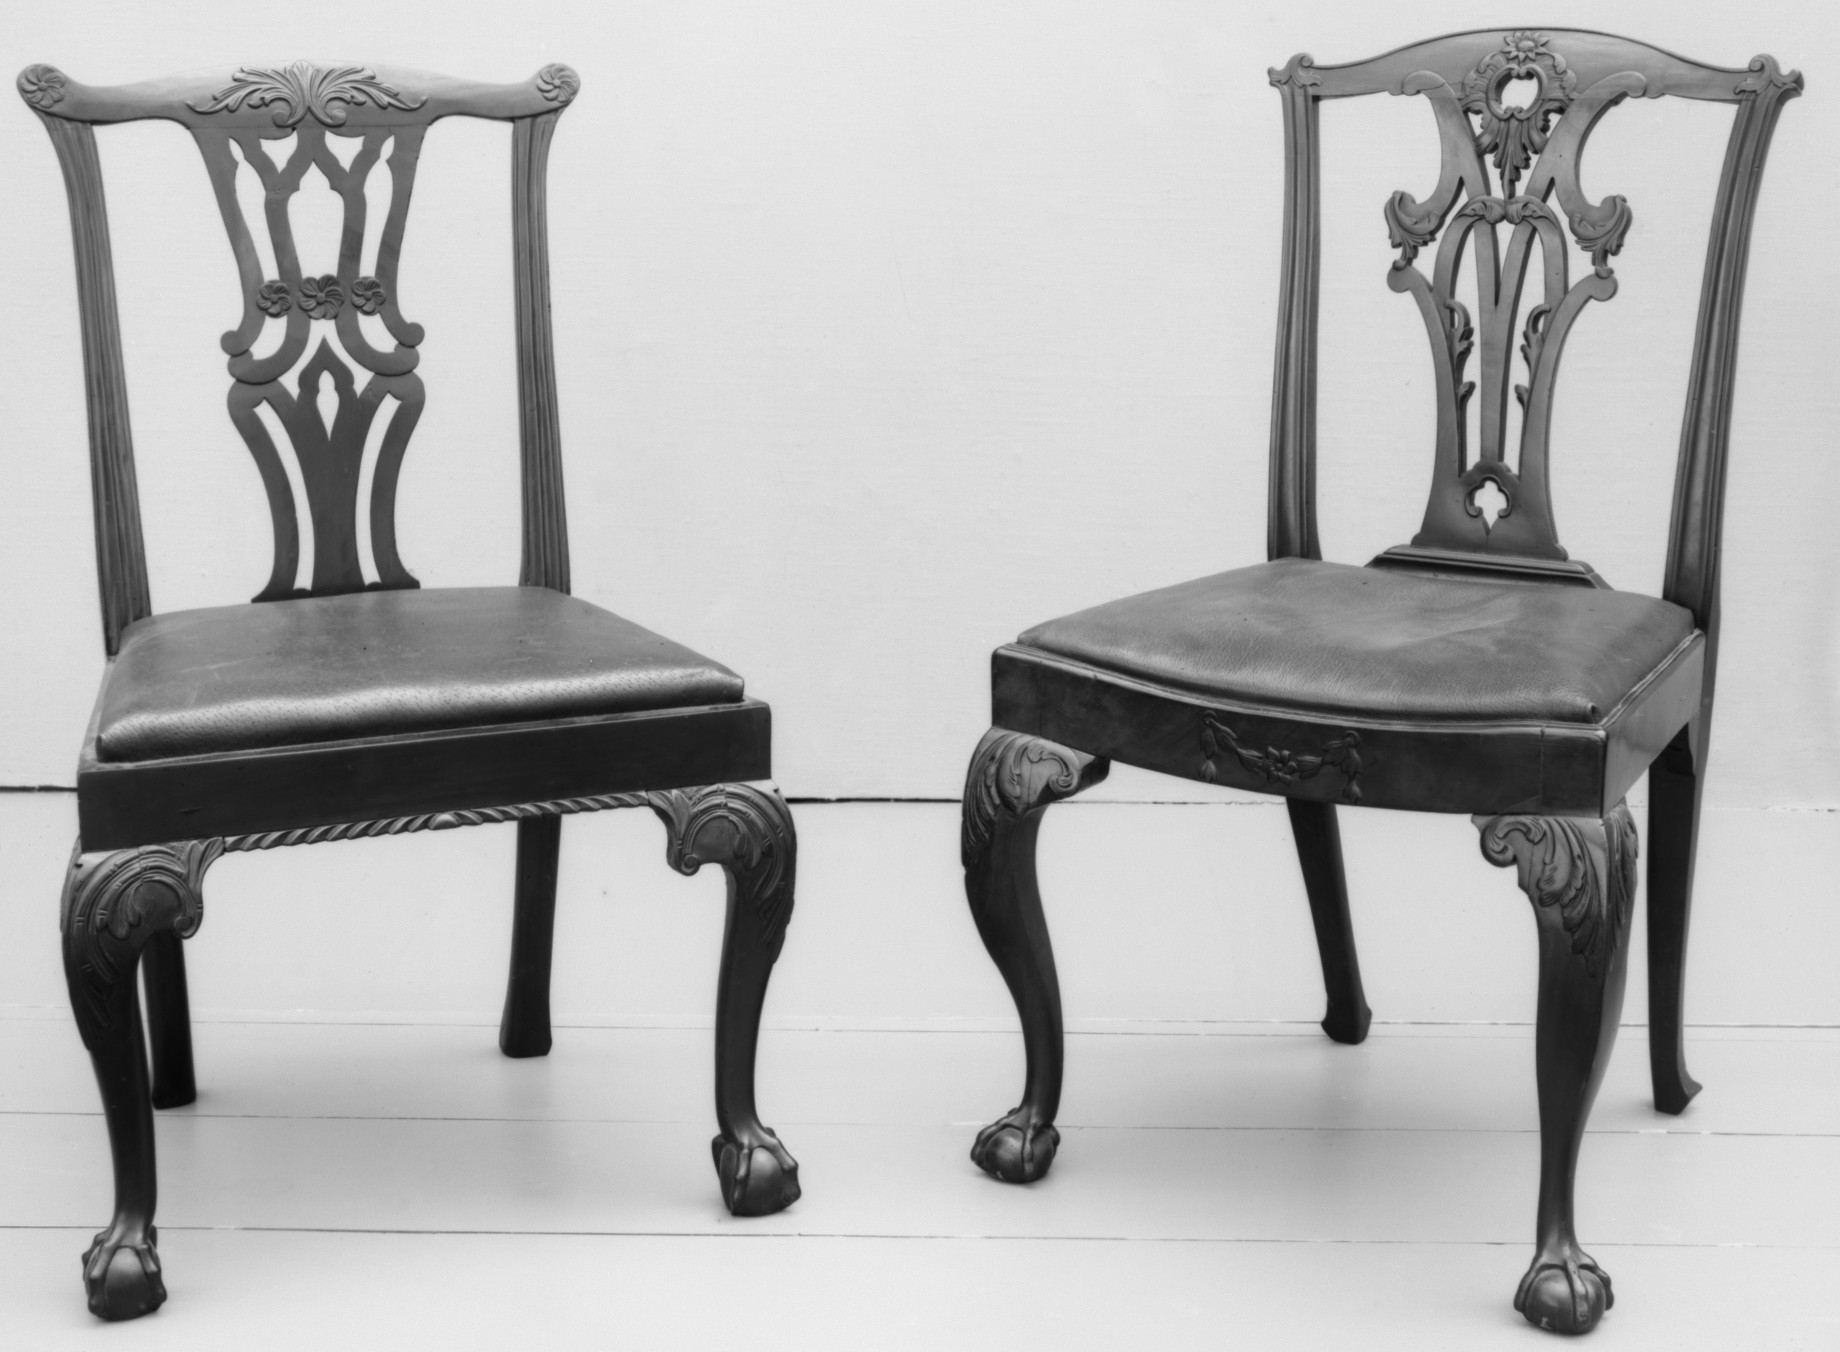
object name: side chair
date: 1750-1760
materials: wood